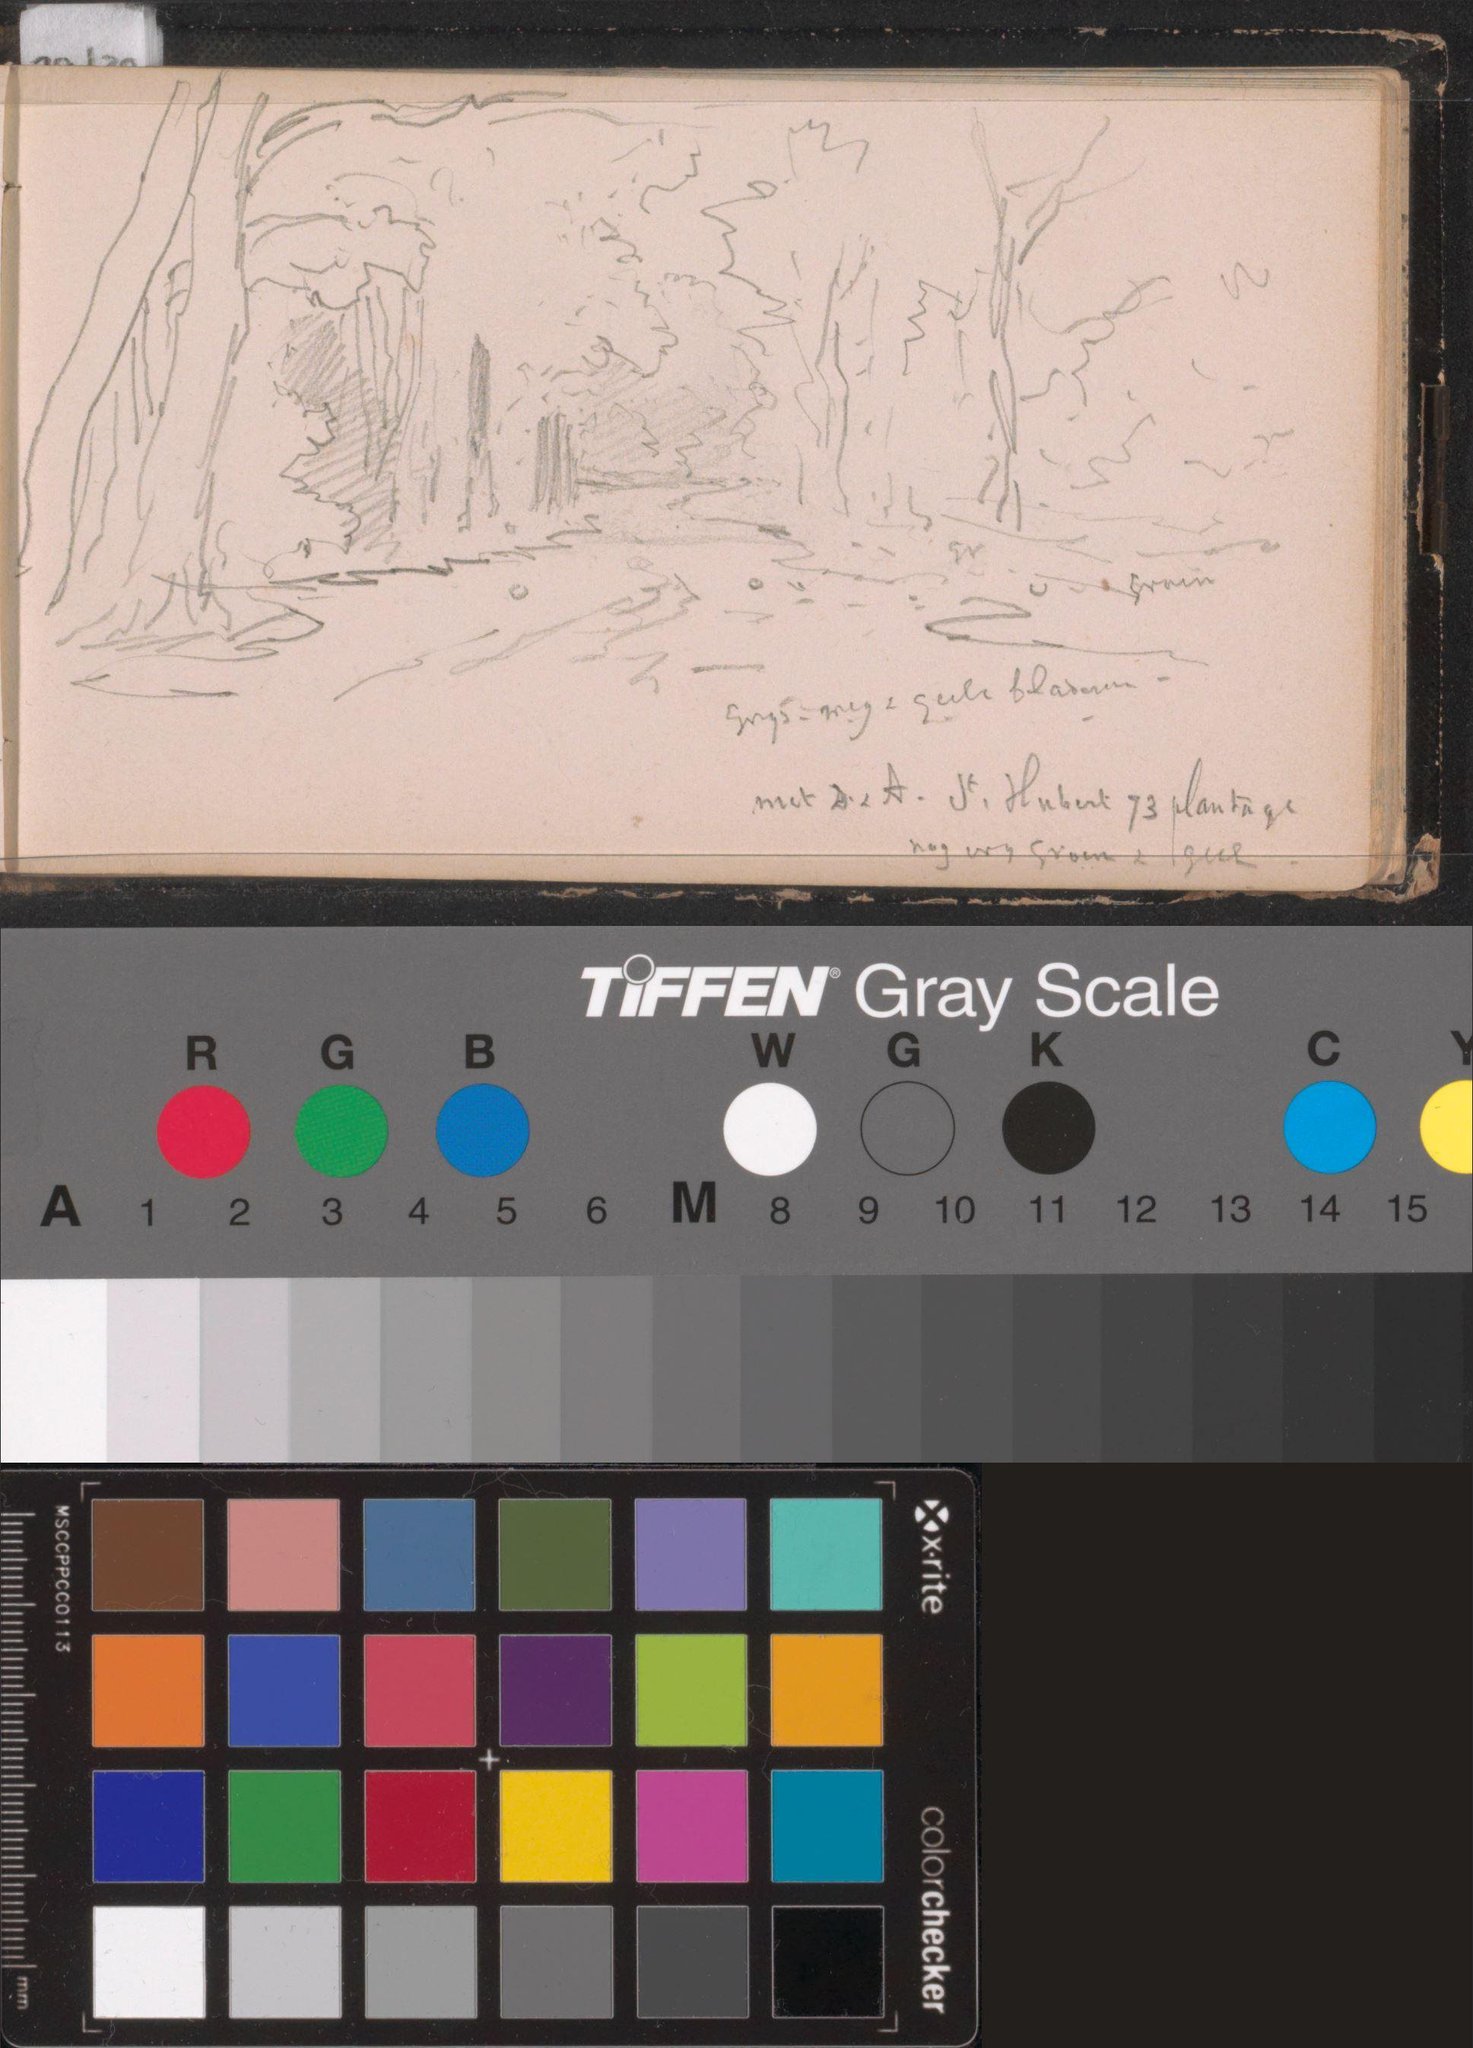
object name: sketchbook leaf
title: Boslaan in Sint Hubert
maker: johannes tavenraat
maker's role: draughtsman, painter, print maker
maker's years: 1809-1881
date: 1873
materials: paper, pencil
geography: sint hubert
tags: forest path or lane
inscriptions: date and inscription: ‘met A & A. St Hubert 73 plantage’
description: Blad 19 recto uit een schetsboek met 46 bladen.